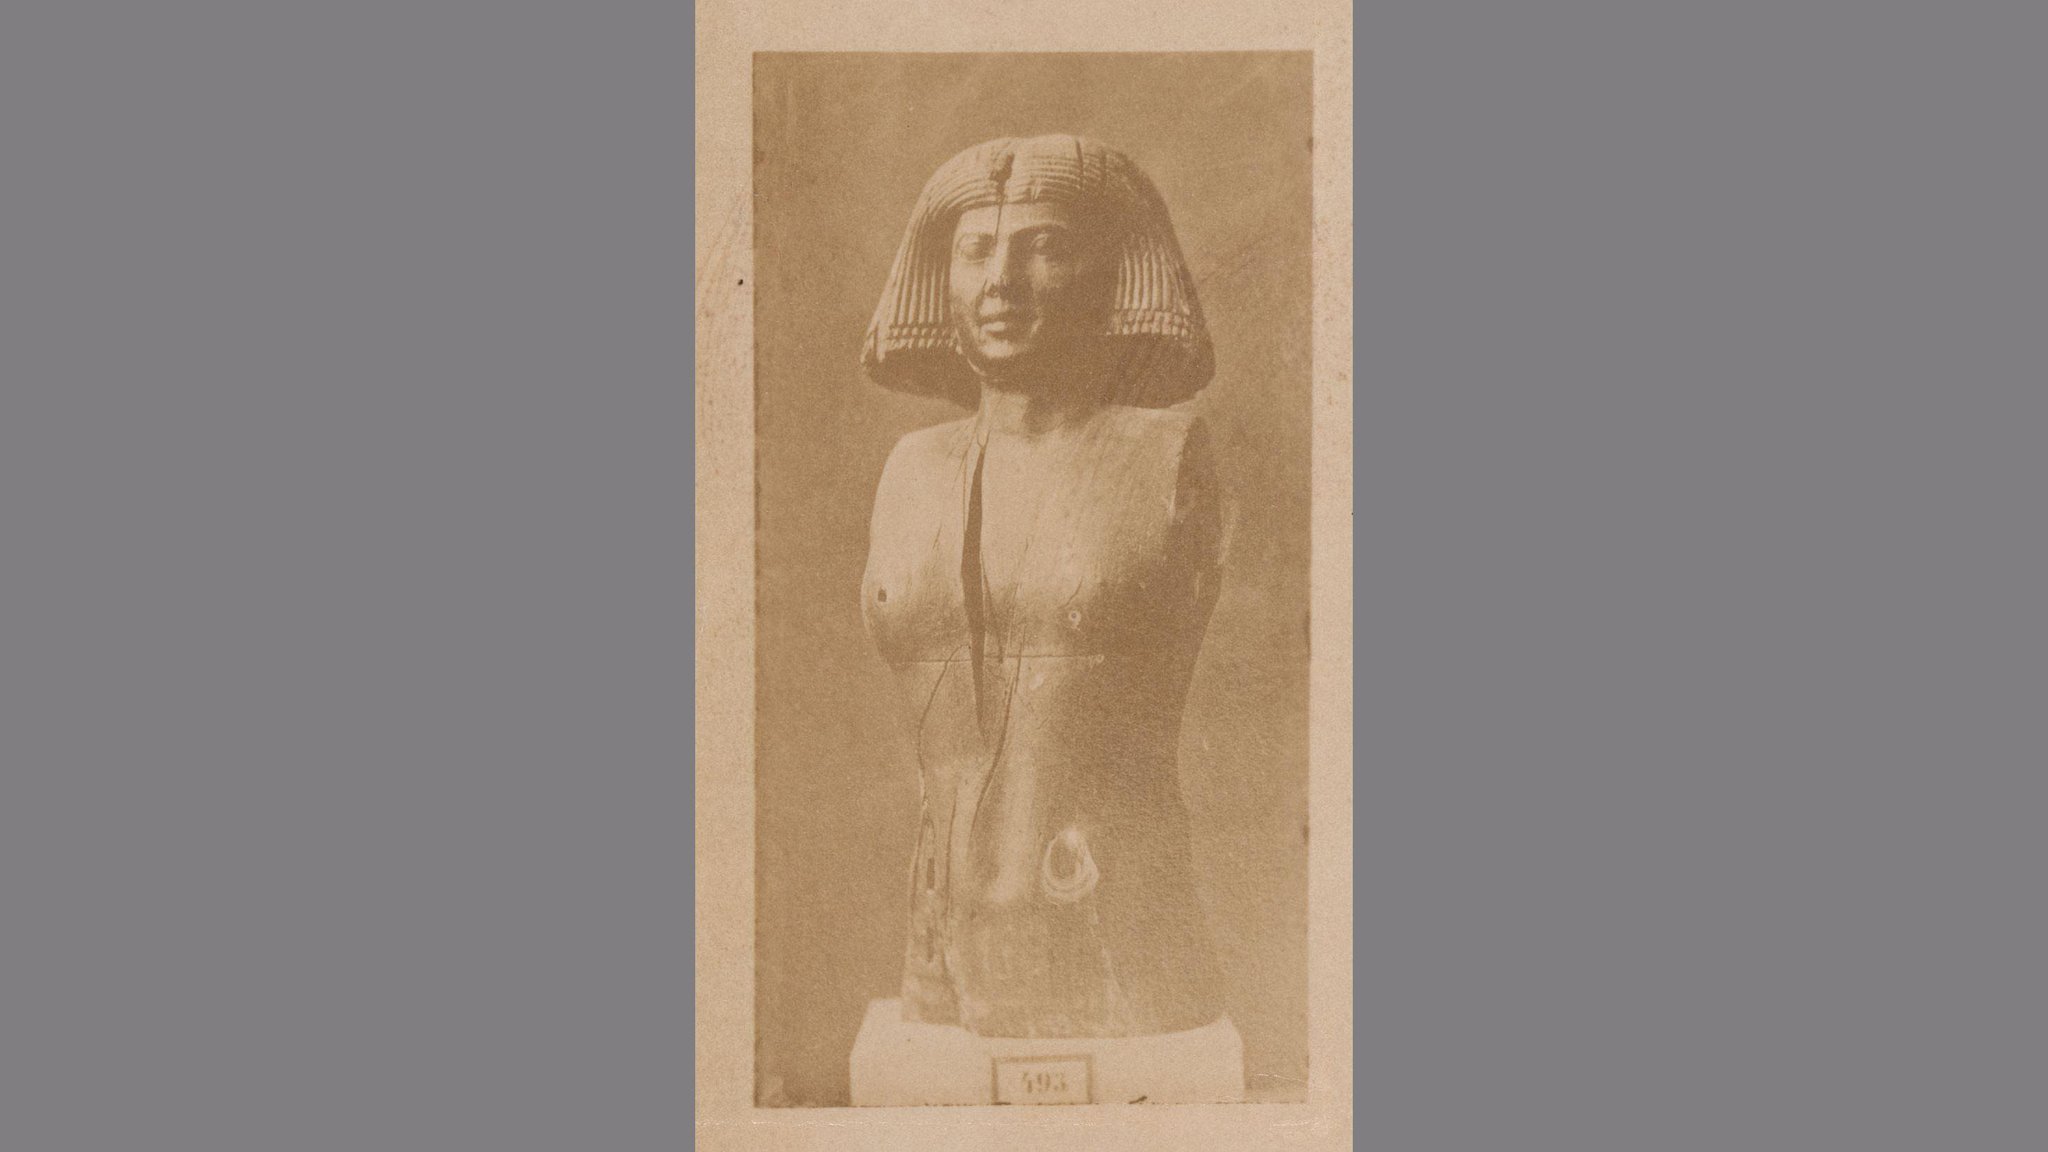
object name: photograph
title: Egyptische sculptuur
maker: Anonymous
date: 1870-1890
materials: paper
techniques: albumen print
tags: piece of sculpture, reproduction of a piece of sculpture